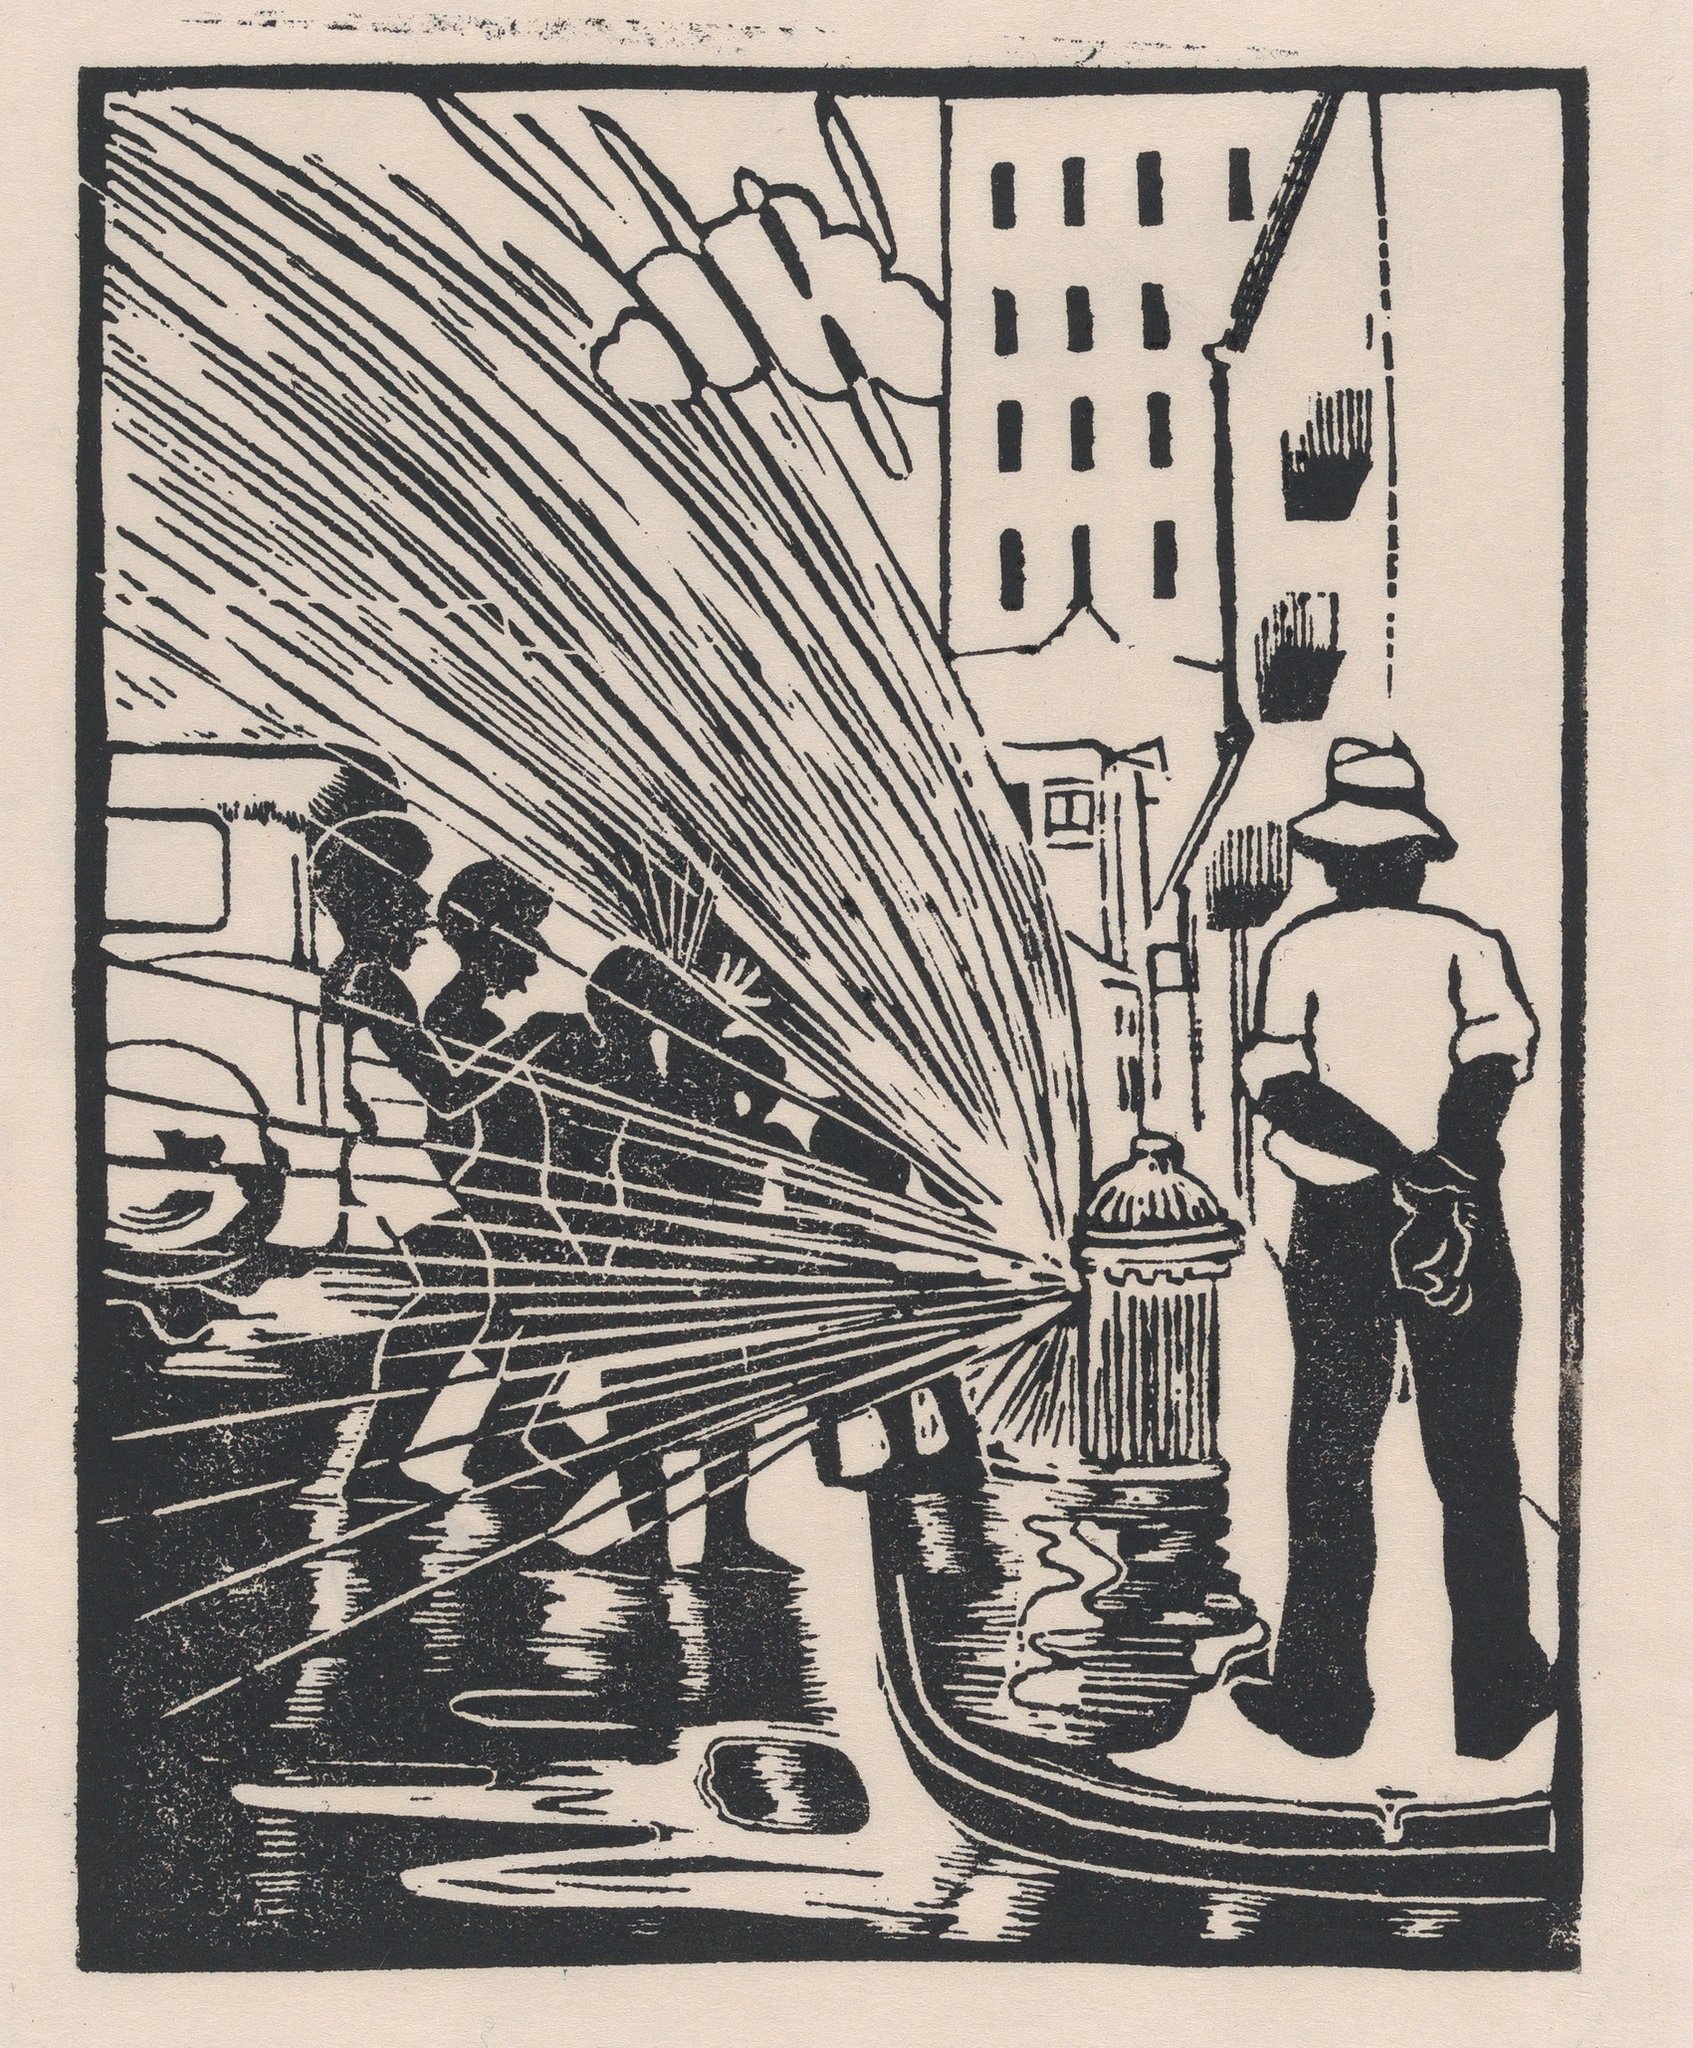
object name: print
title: Fireplug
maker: samuel joseph brown, jr.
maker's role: artist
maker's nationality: american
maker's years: 1907-1994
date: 1940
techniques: linocut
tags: streets,men,women